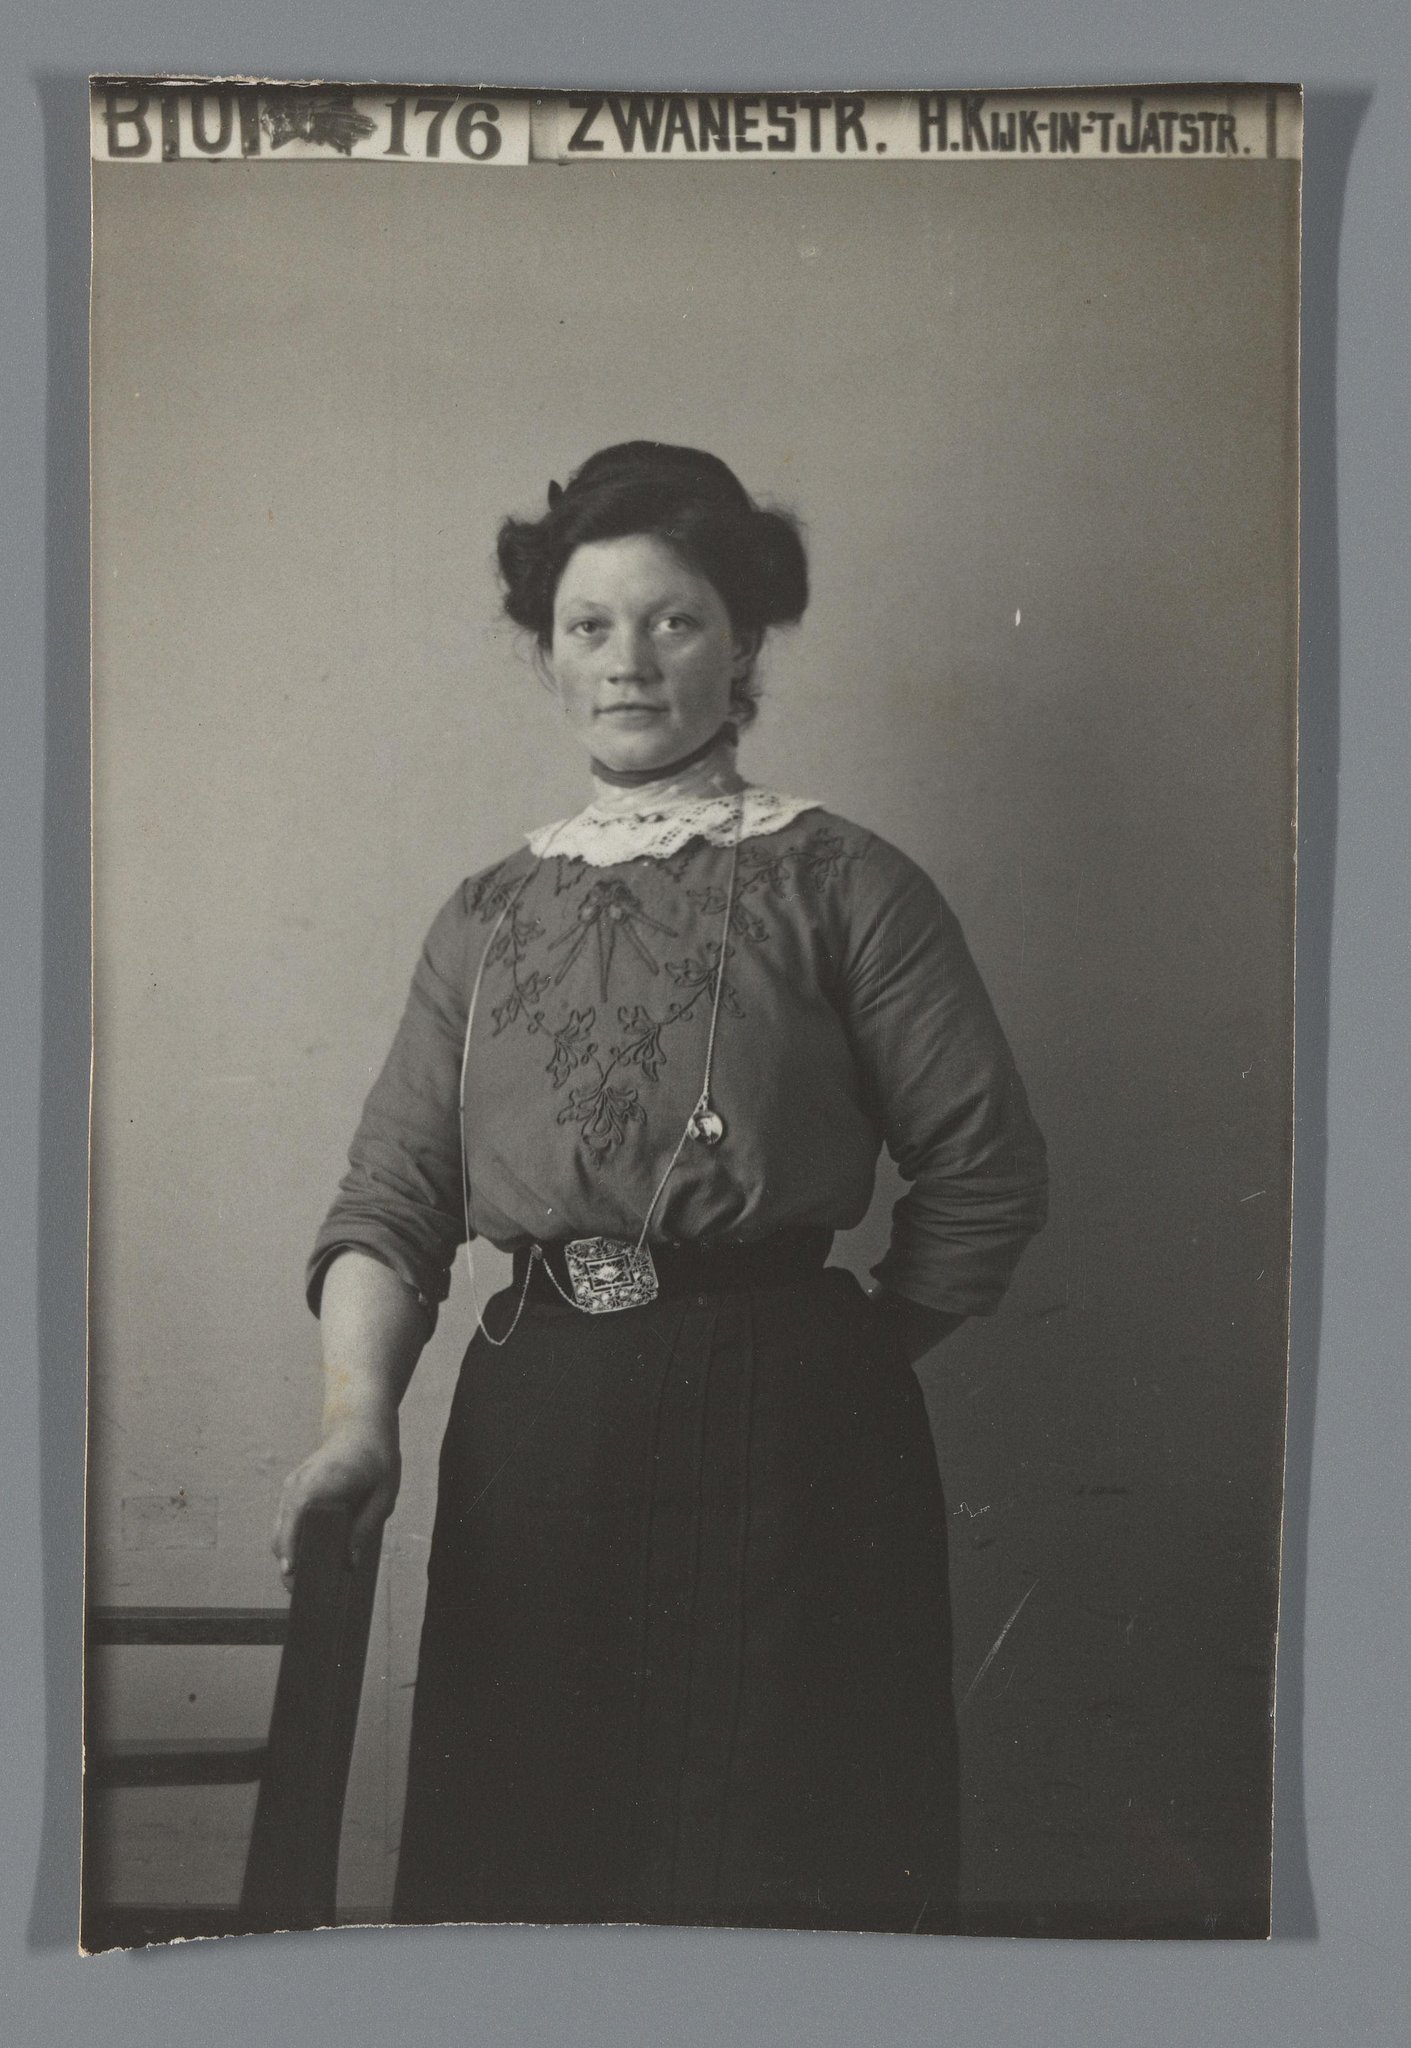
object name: snapshot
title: Portret van een vrouw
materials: photographic support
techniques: gelatin silver print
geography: groningen